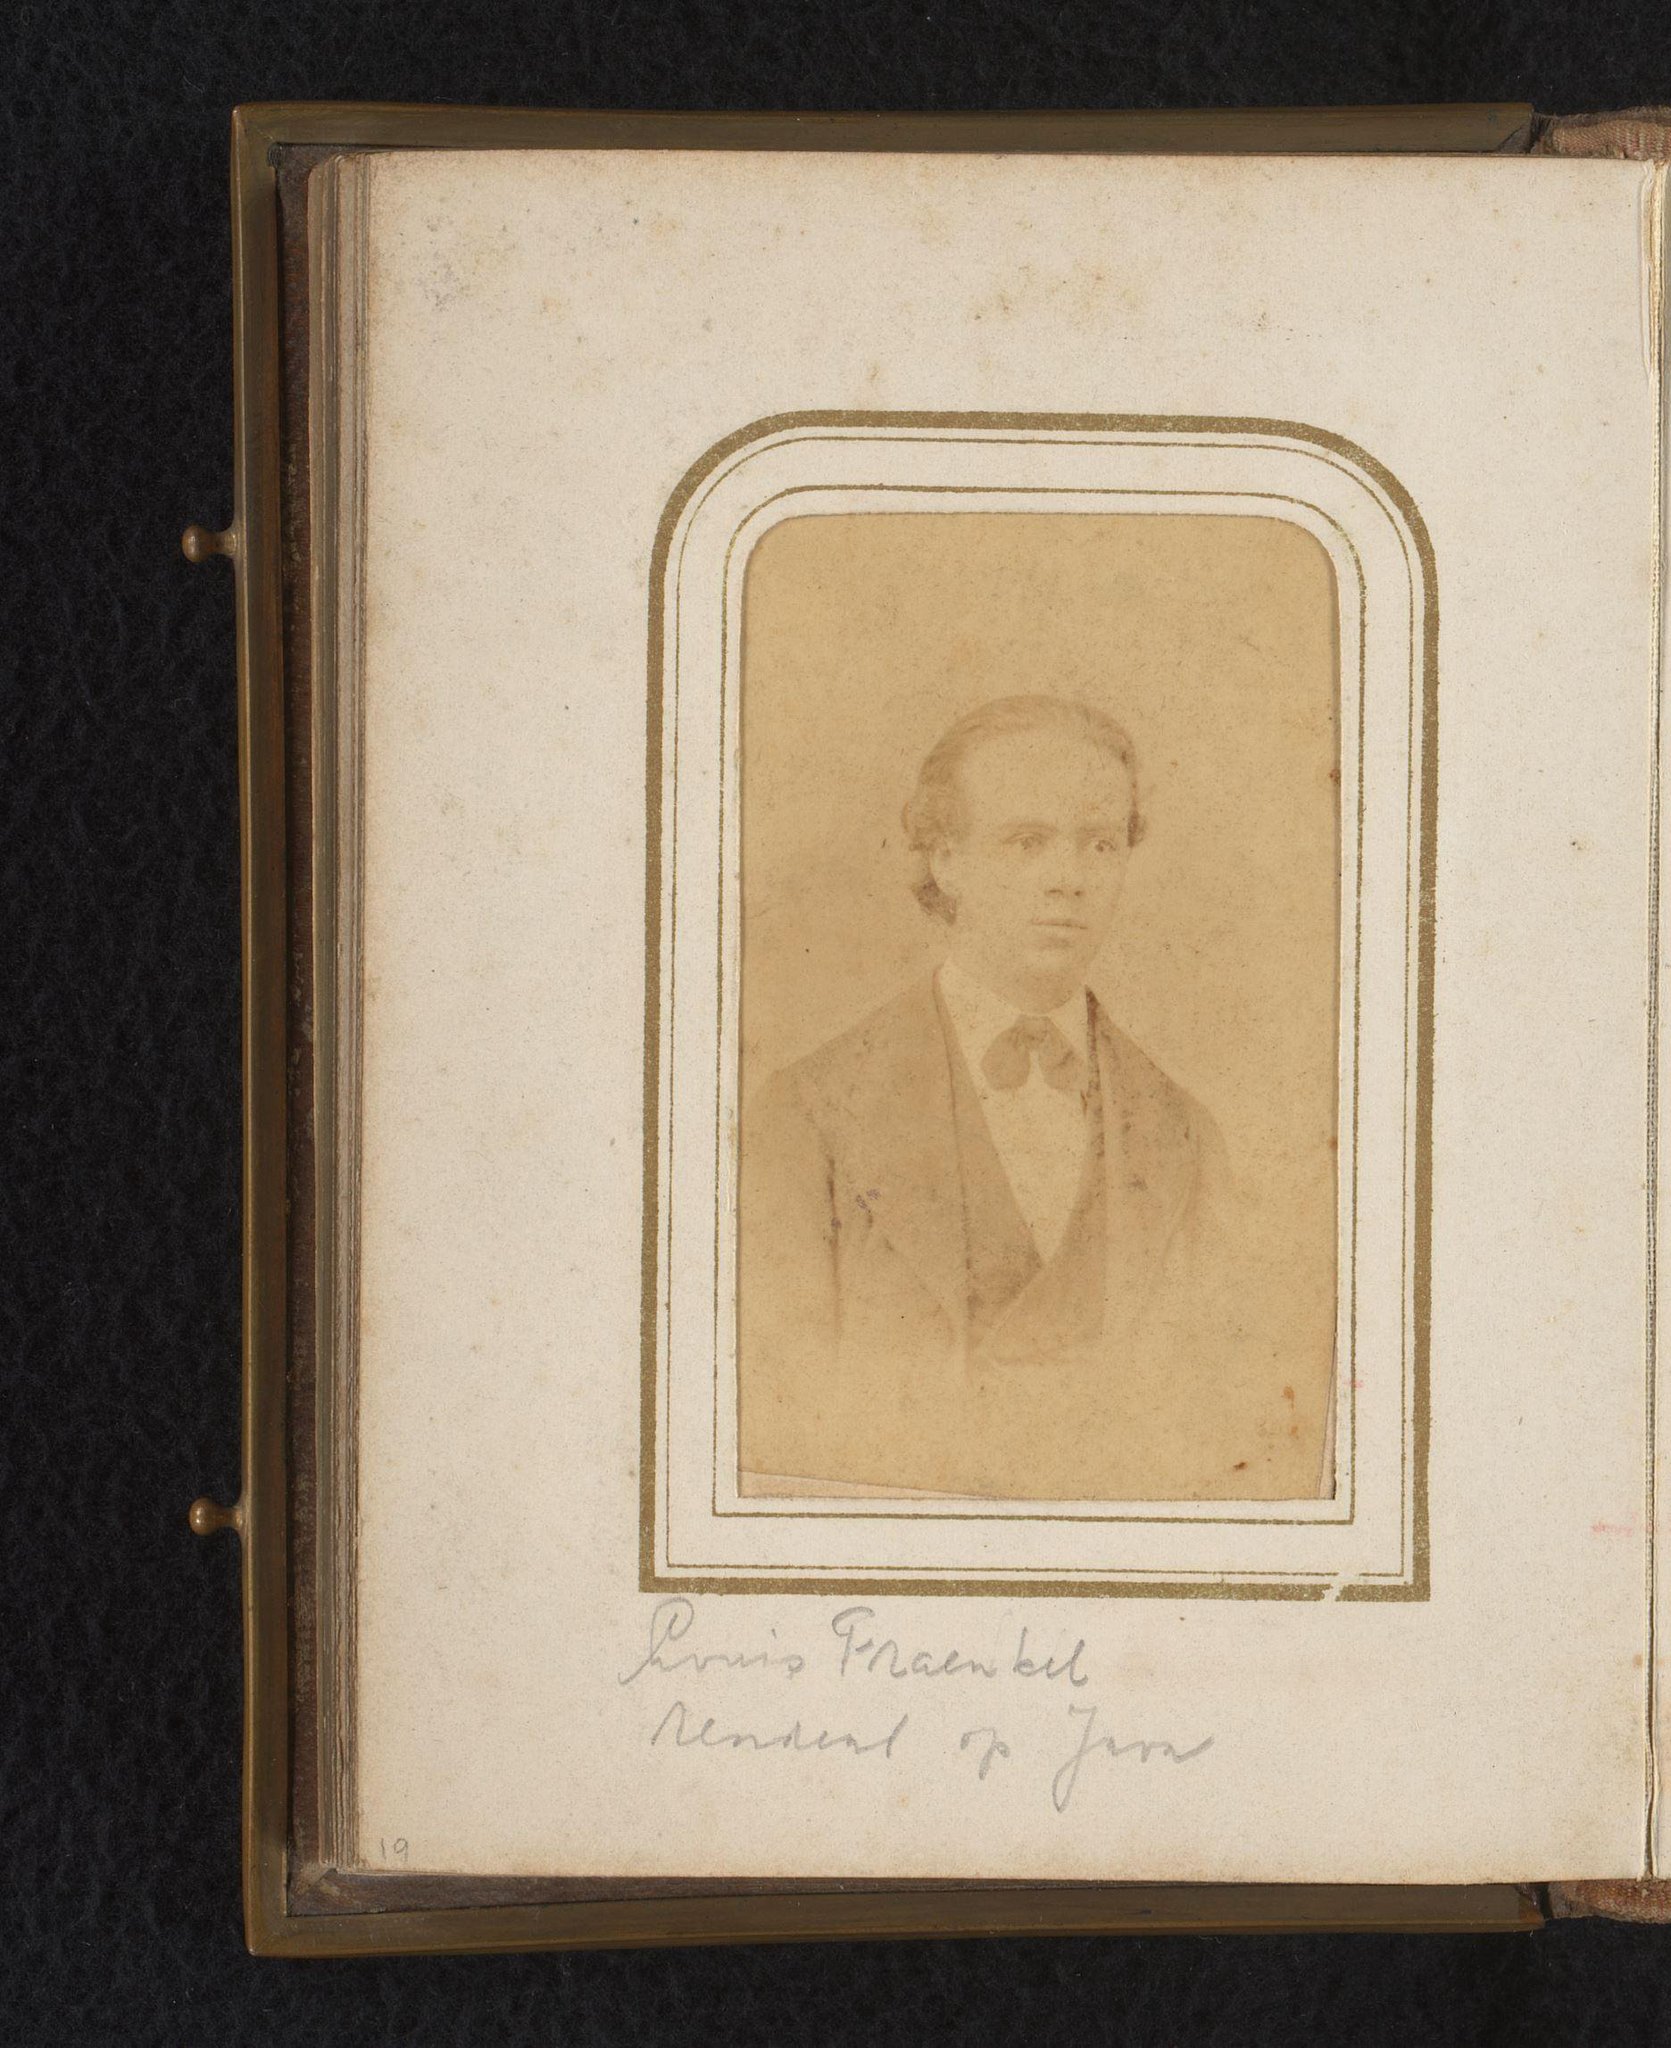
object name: carte de visite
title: Portret van een man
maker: christiaan martinus jan hermelink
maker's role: fotograaf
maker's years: 1840-1933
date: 1867-1885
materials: cardboard, photographic support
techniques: albumen print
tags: adult man, historical persons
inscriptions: annotation: ‘Louis [Fraenkil]/ [...] op Java’, annotation: ‘Louis [Fraenkil]/ [...] op/ Java’, inscription: ‘C.M.J. Hermelink/ 62 Dennenweg/ 's Gravenhage (...)’, number: ‘32946’